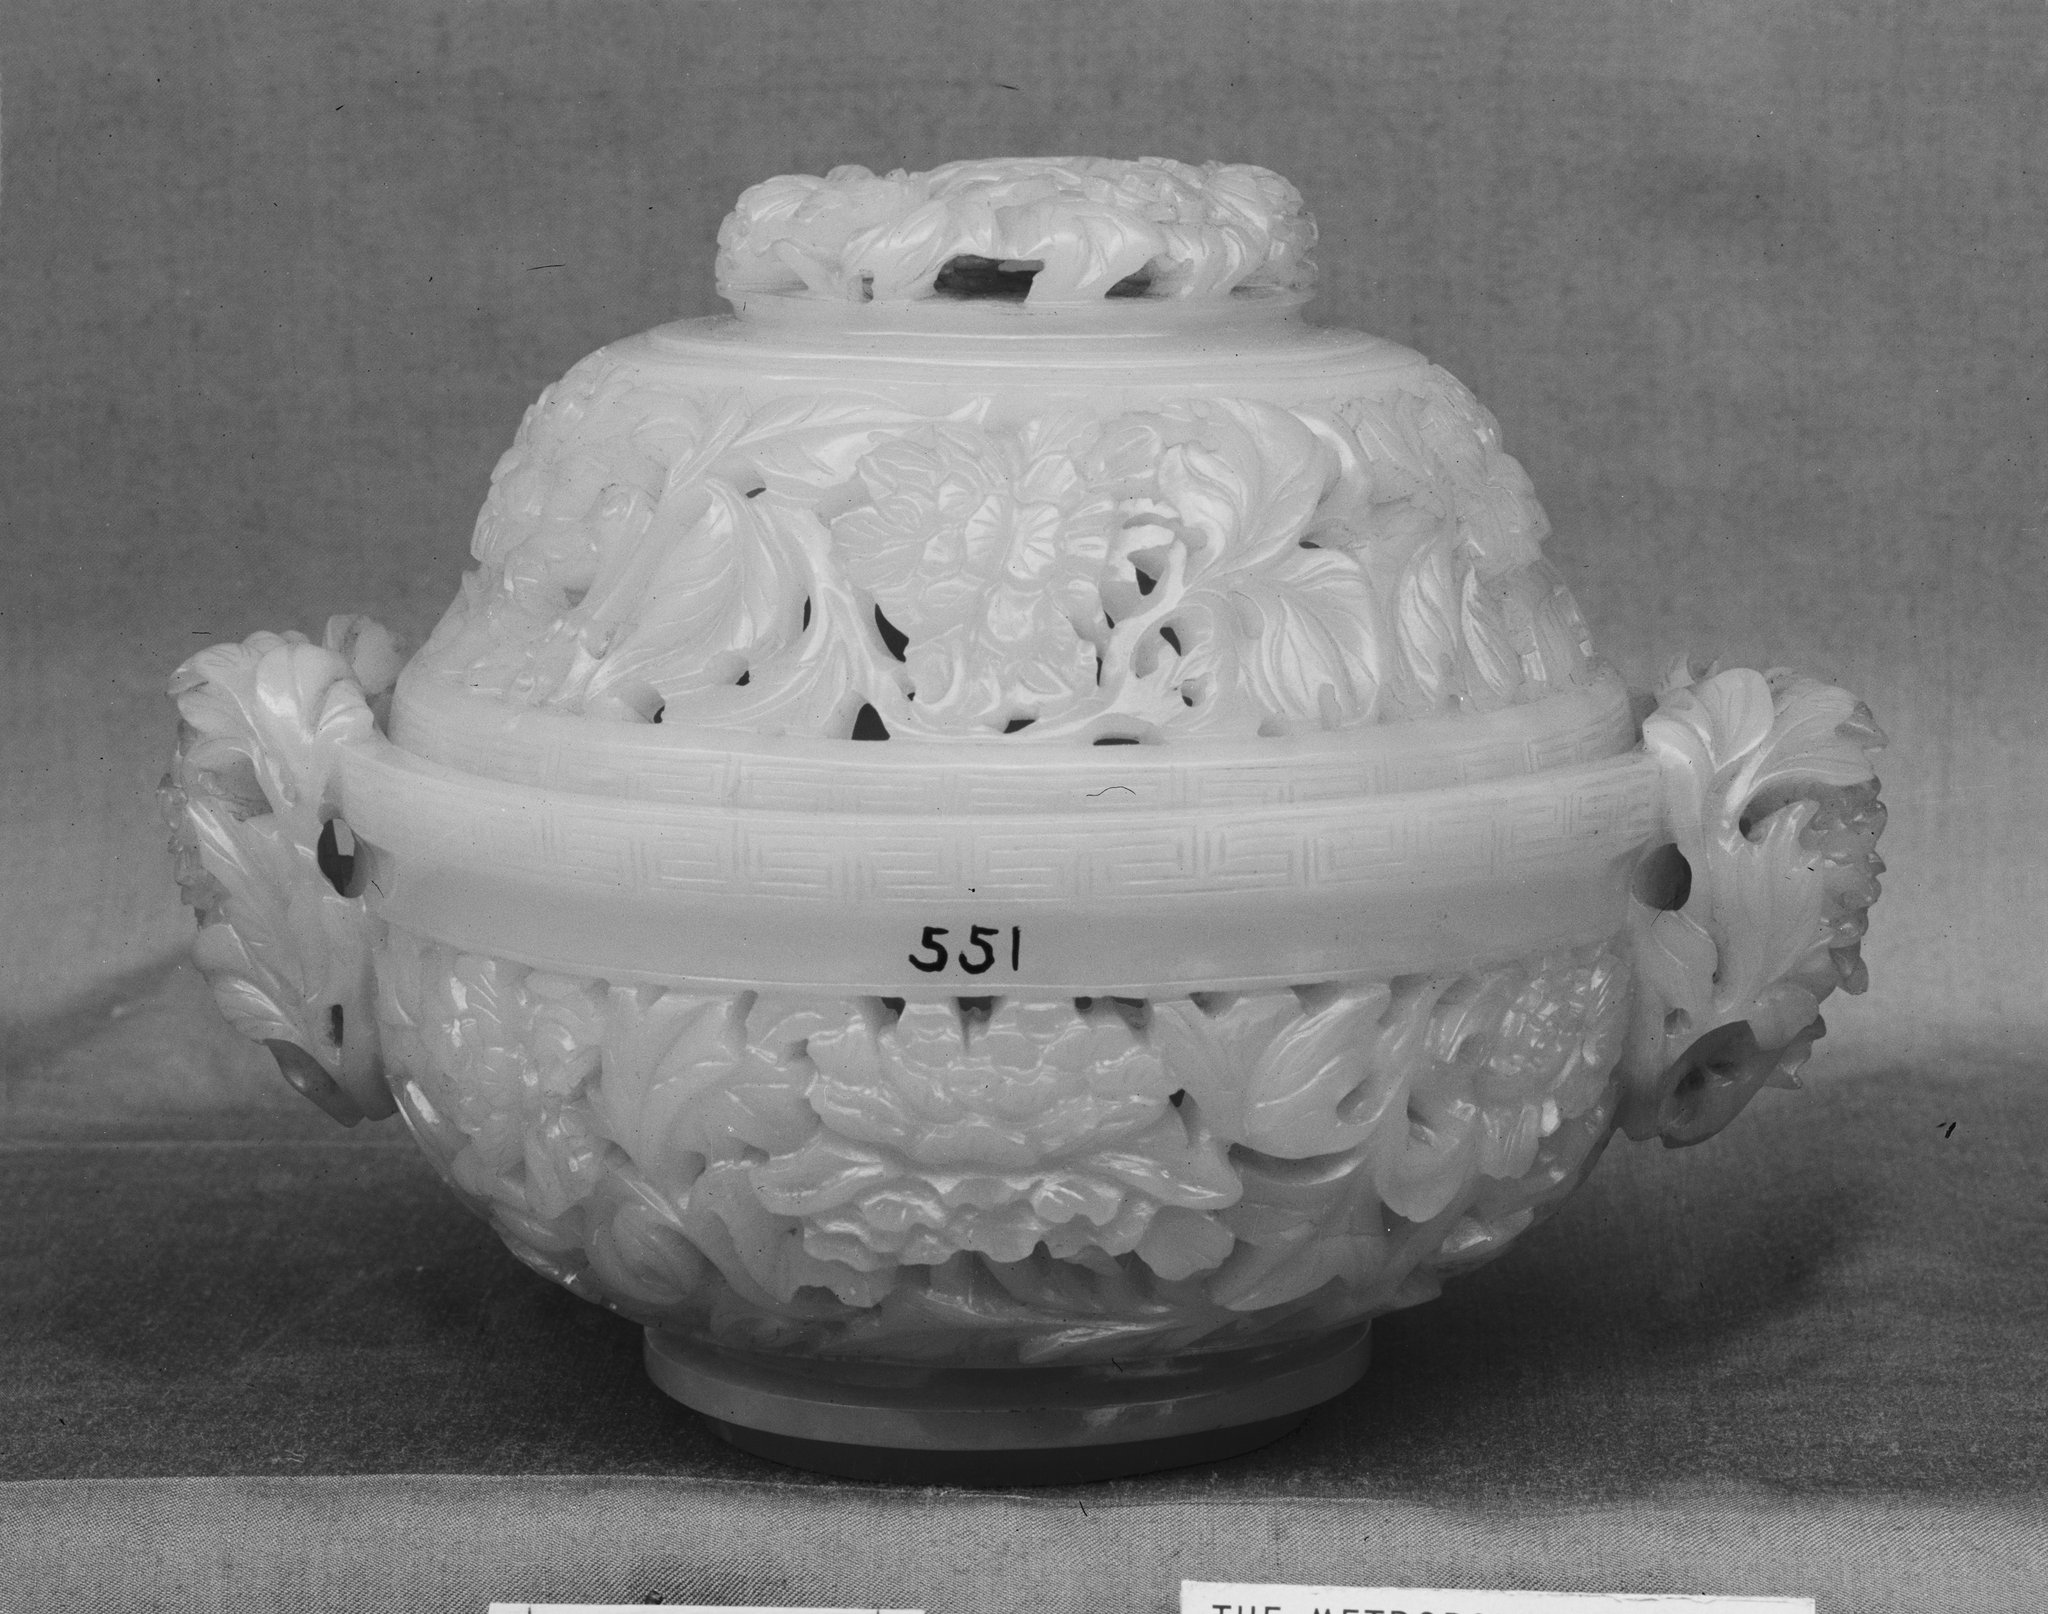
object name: incense burner with cover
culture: chinese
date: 1736-1795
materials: jade